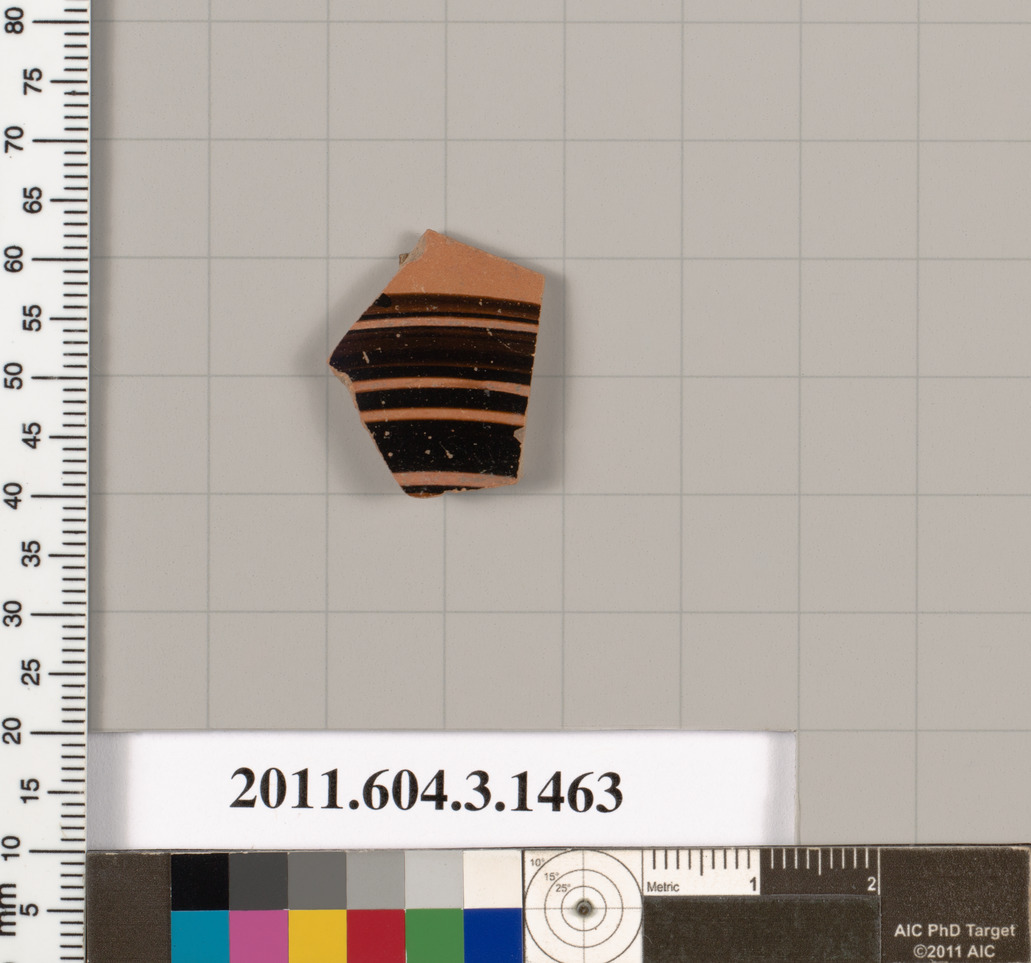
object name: skyphos fragment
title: Terracotta fragment of a skyphos (deep drinking cup)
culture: greek, attic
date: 600-401 BCE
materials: terracotta